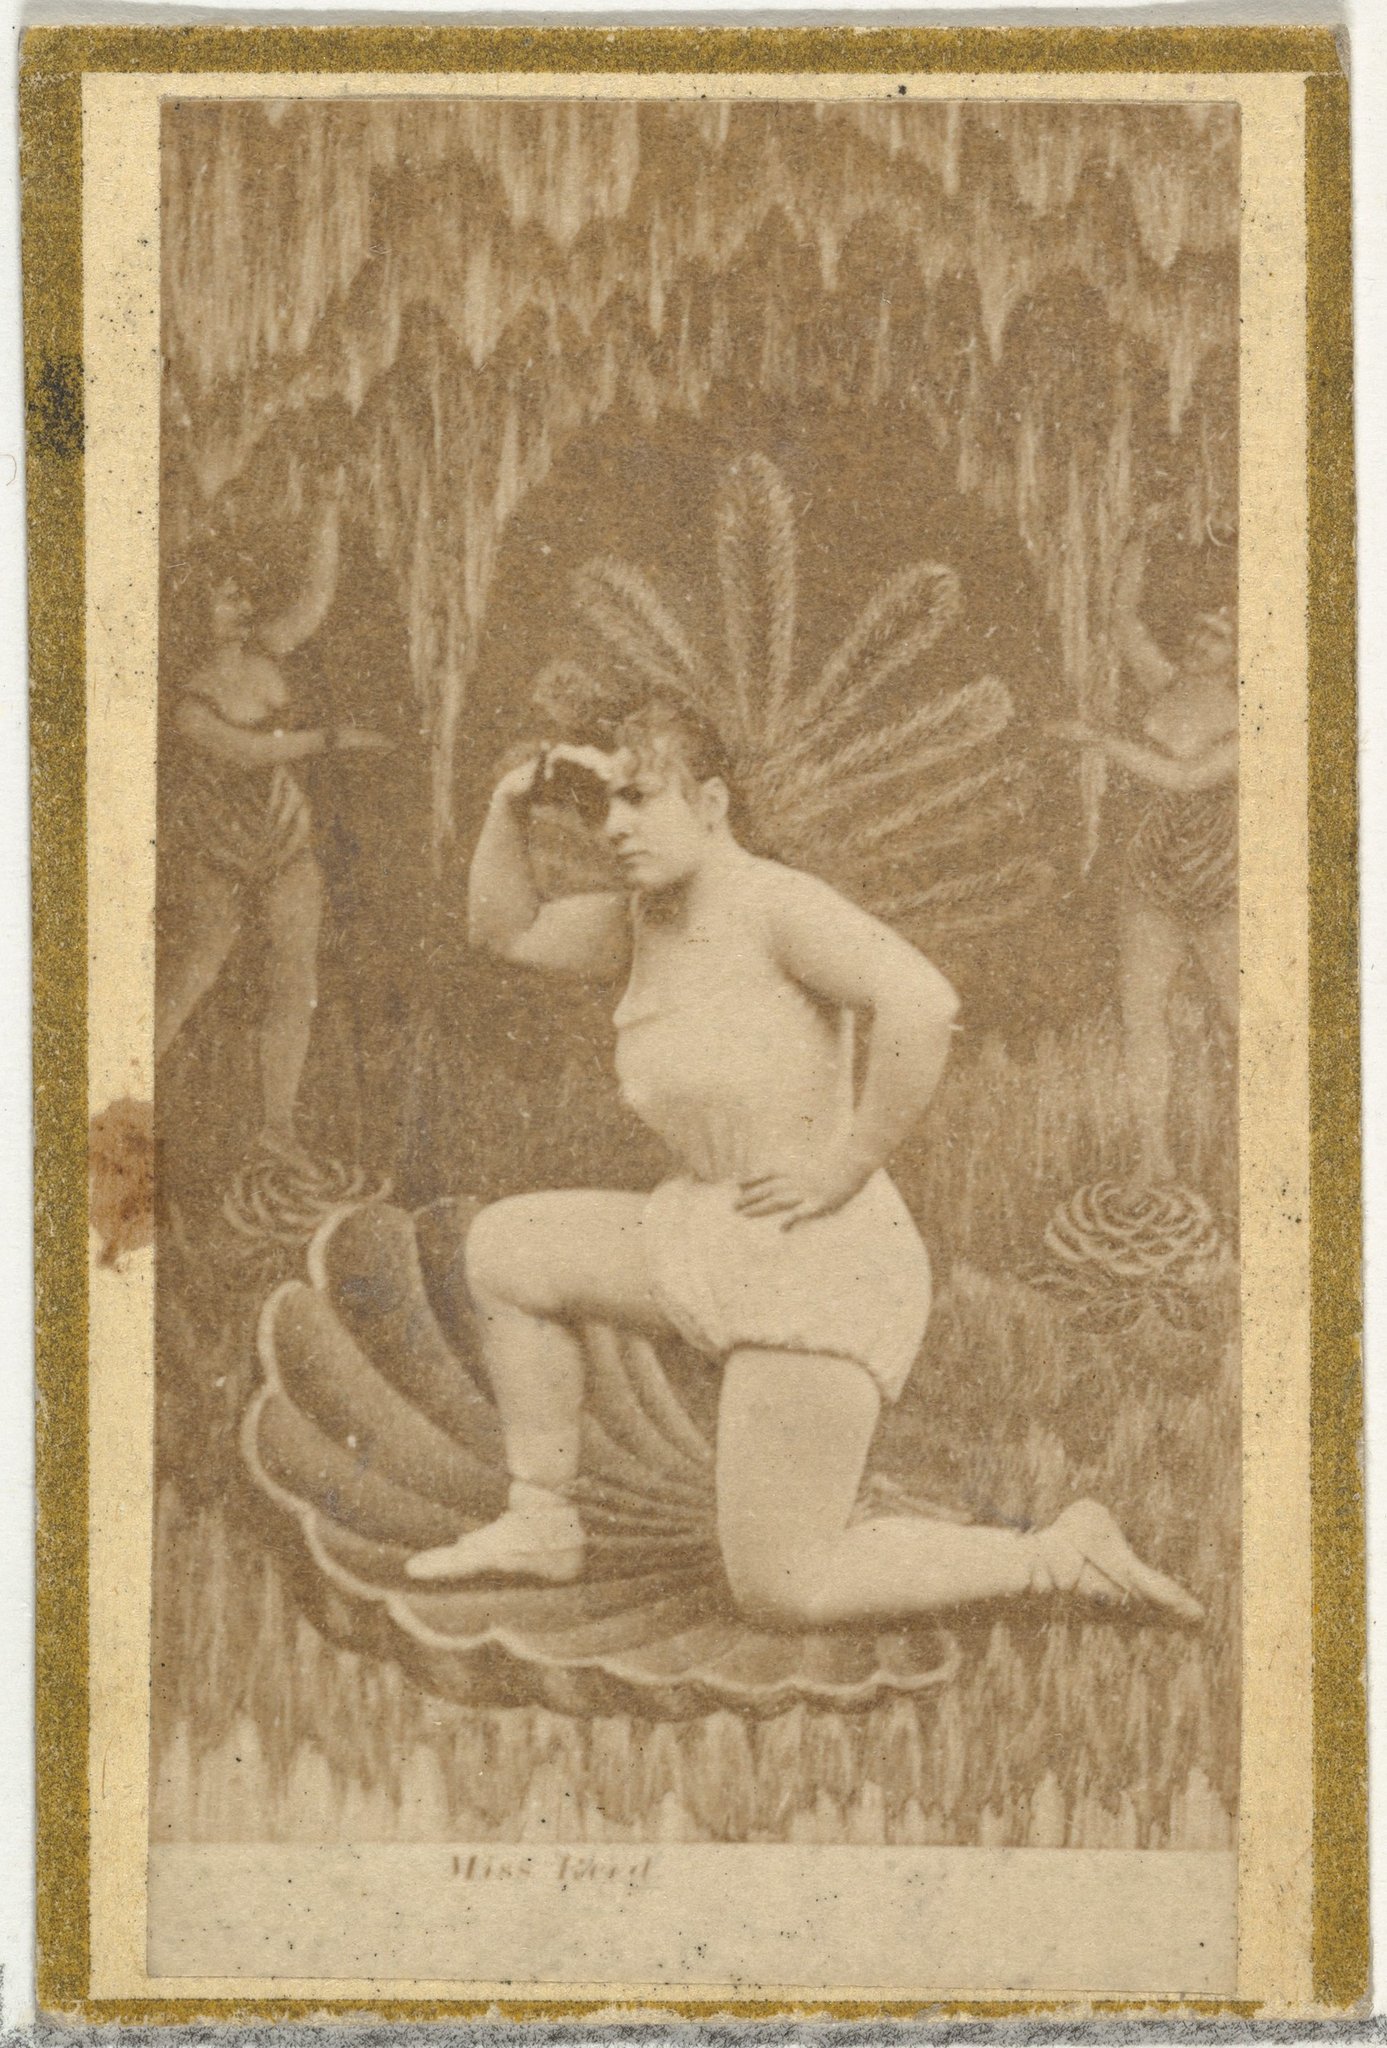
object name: photograph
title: From the Actresses and Celebrities series (N60, Type 2) promoting Little Beauties Cigarettes for Allen & Ginter brand tobacco products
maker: allen & ginter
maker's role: publisher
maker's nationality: american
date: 1887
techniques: albumen silver print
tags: portraits,women,actresses